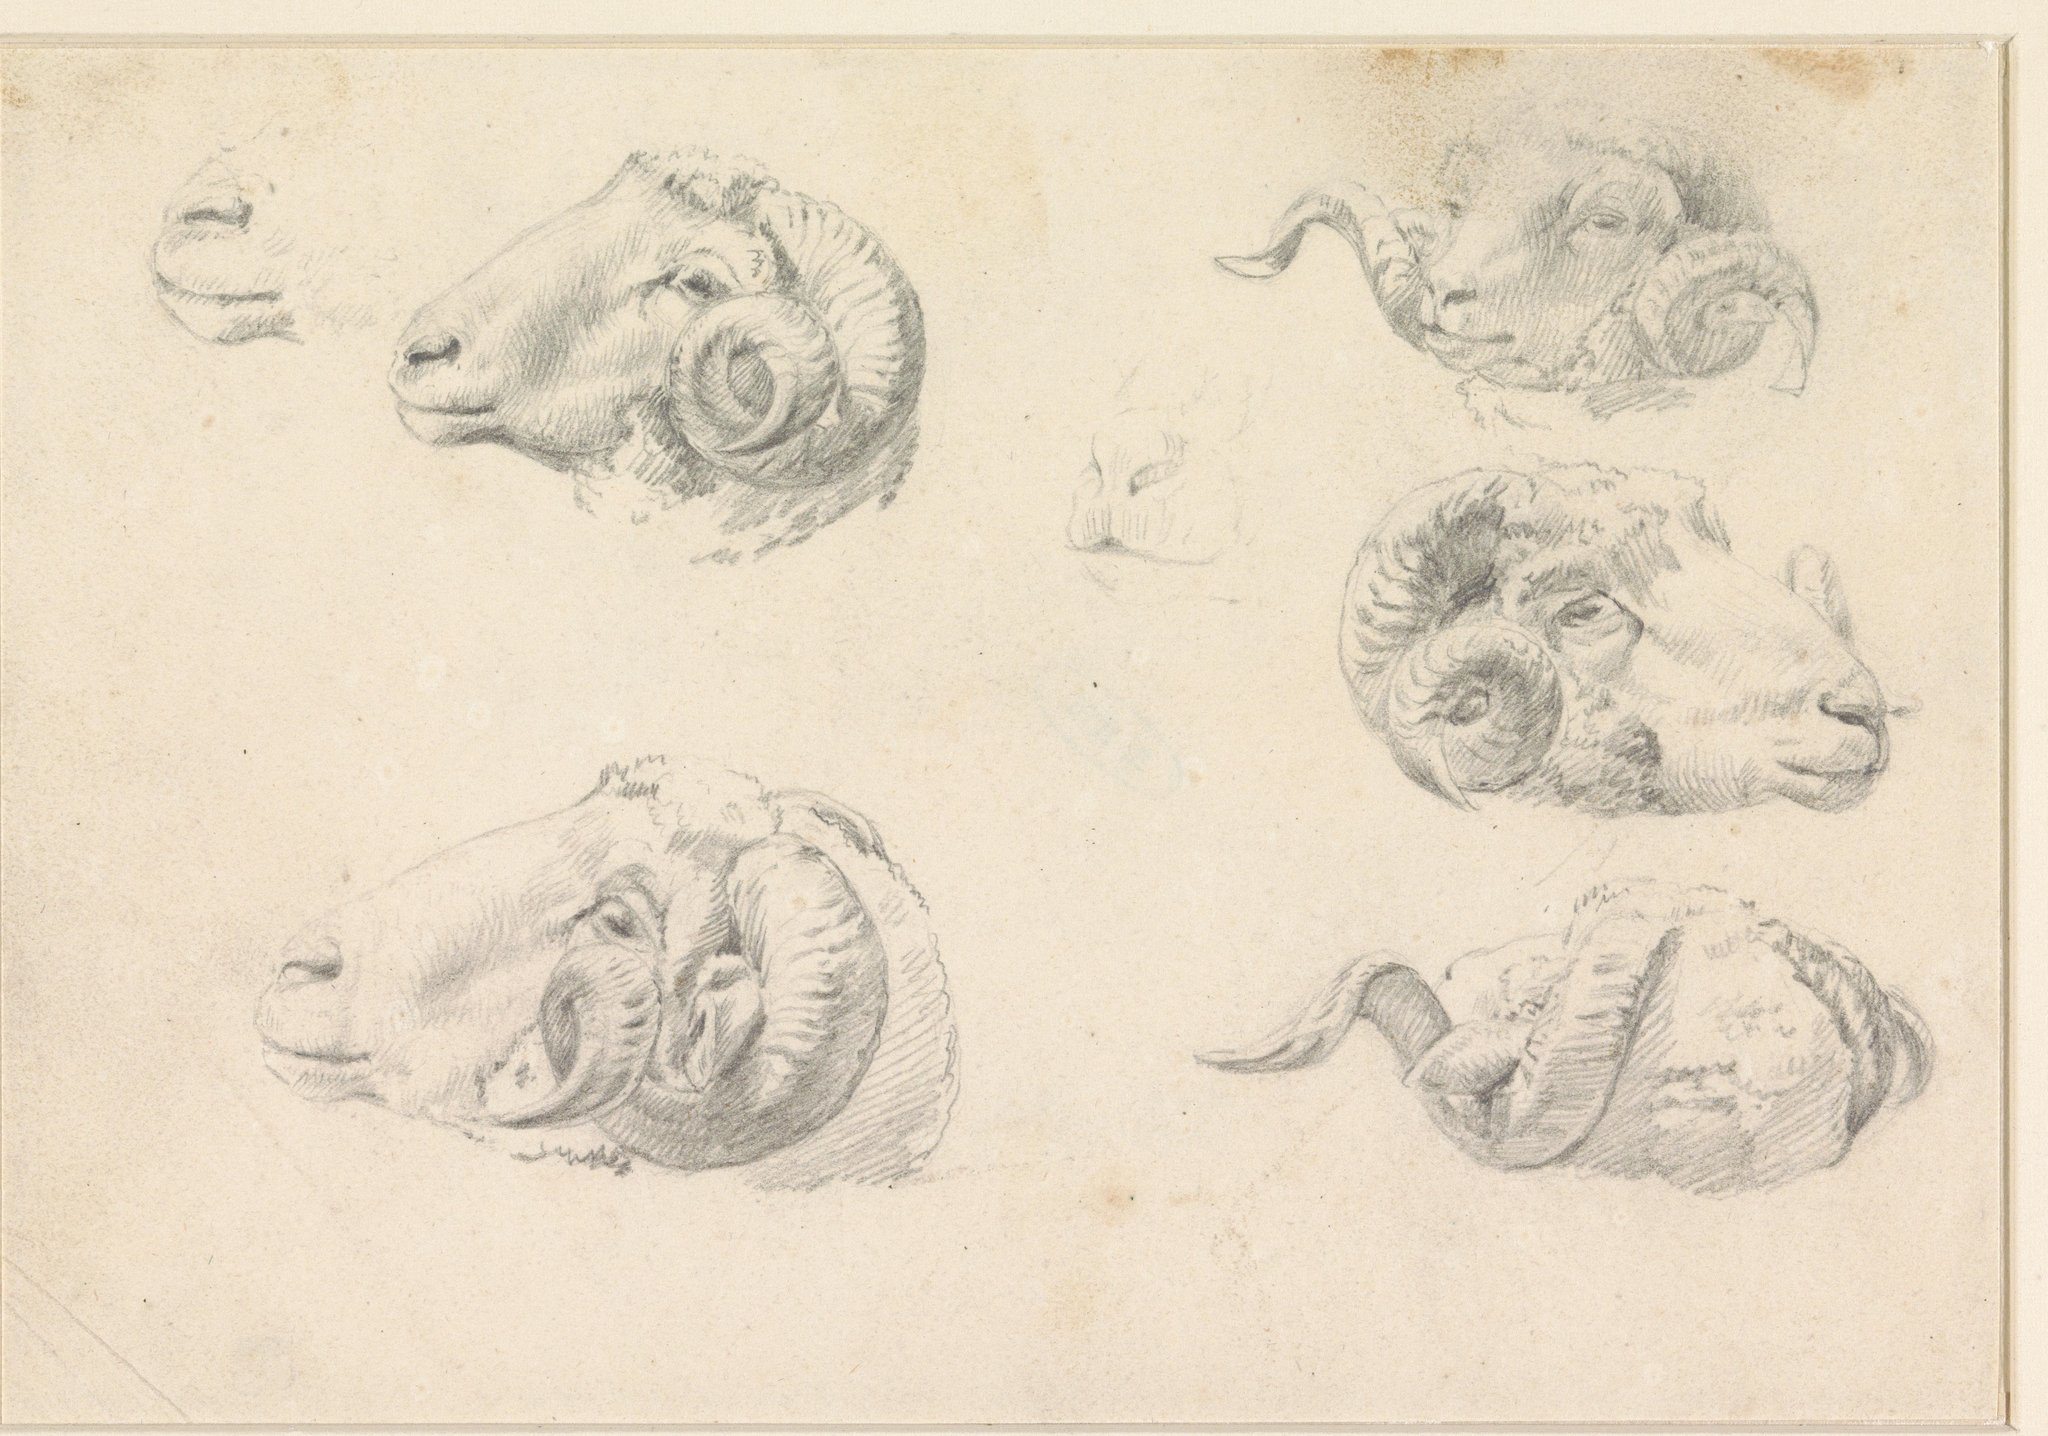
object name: drawing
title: Vijf studies van ramskoppen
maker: hendrik jozef franciscus van der poorten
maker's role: draughtsman, print maker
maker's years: 1789-1874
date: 1840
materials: paper, pencil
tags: ram (+ head of an animal)